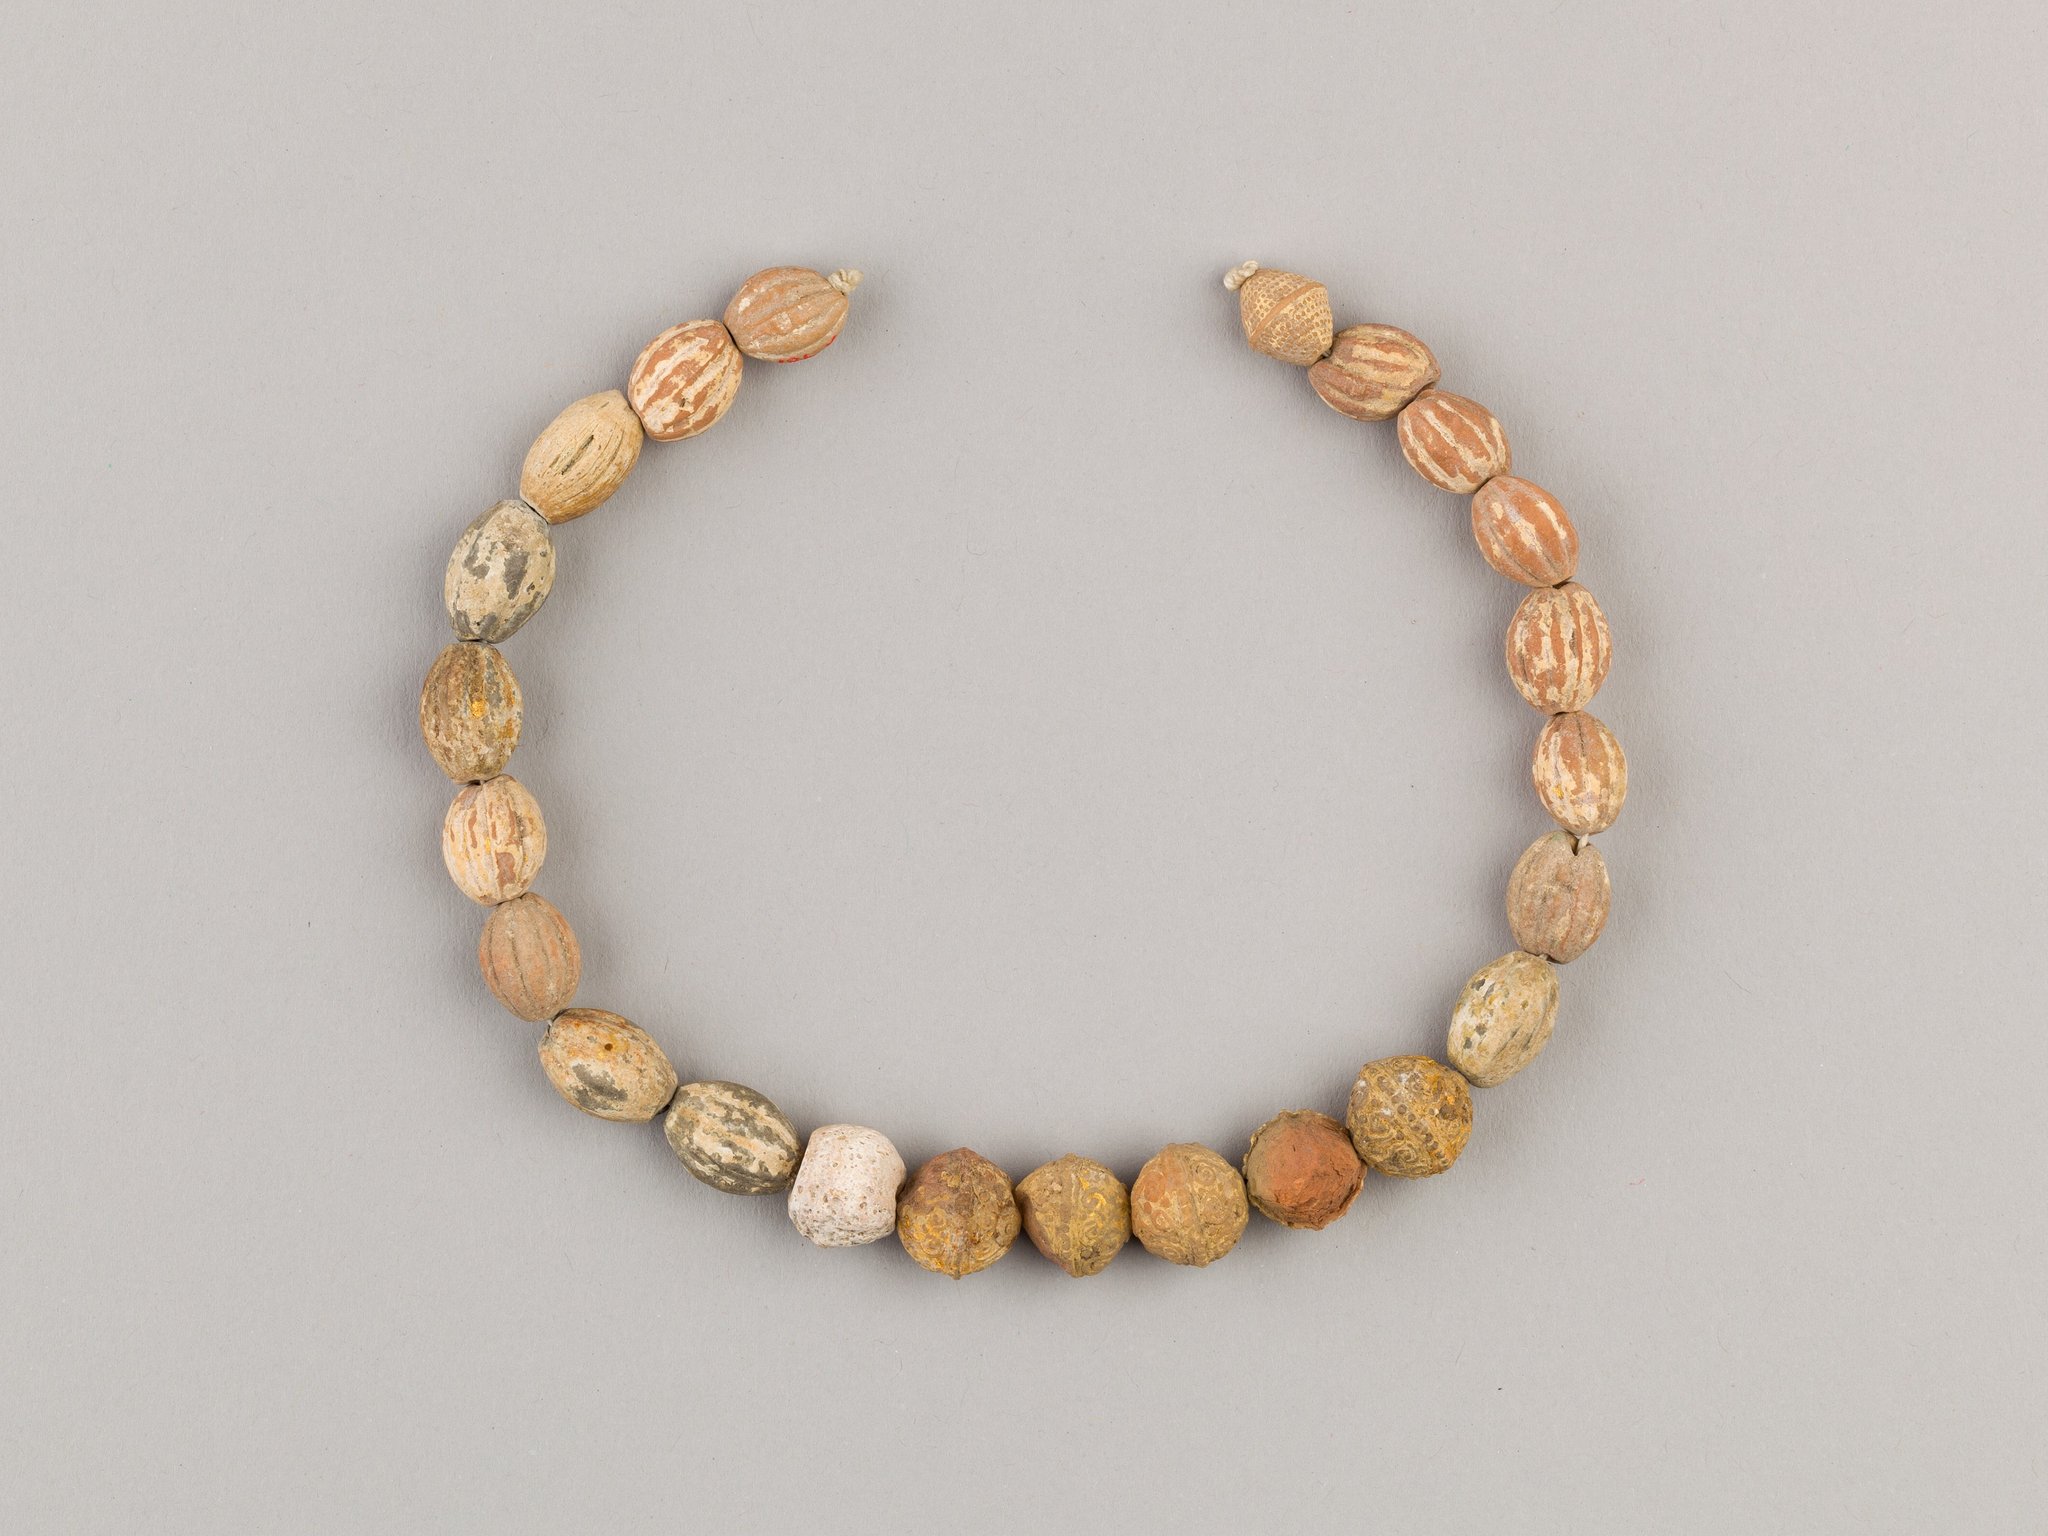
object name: bead, string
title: String of 23 beads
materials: terracotta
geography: egypt